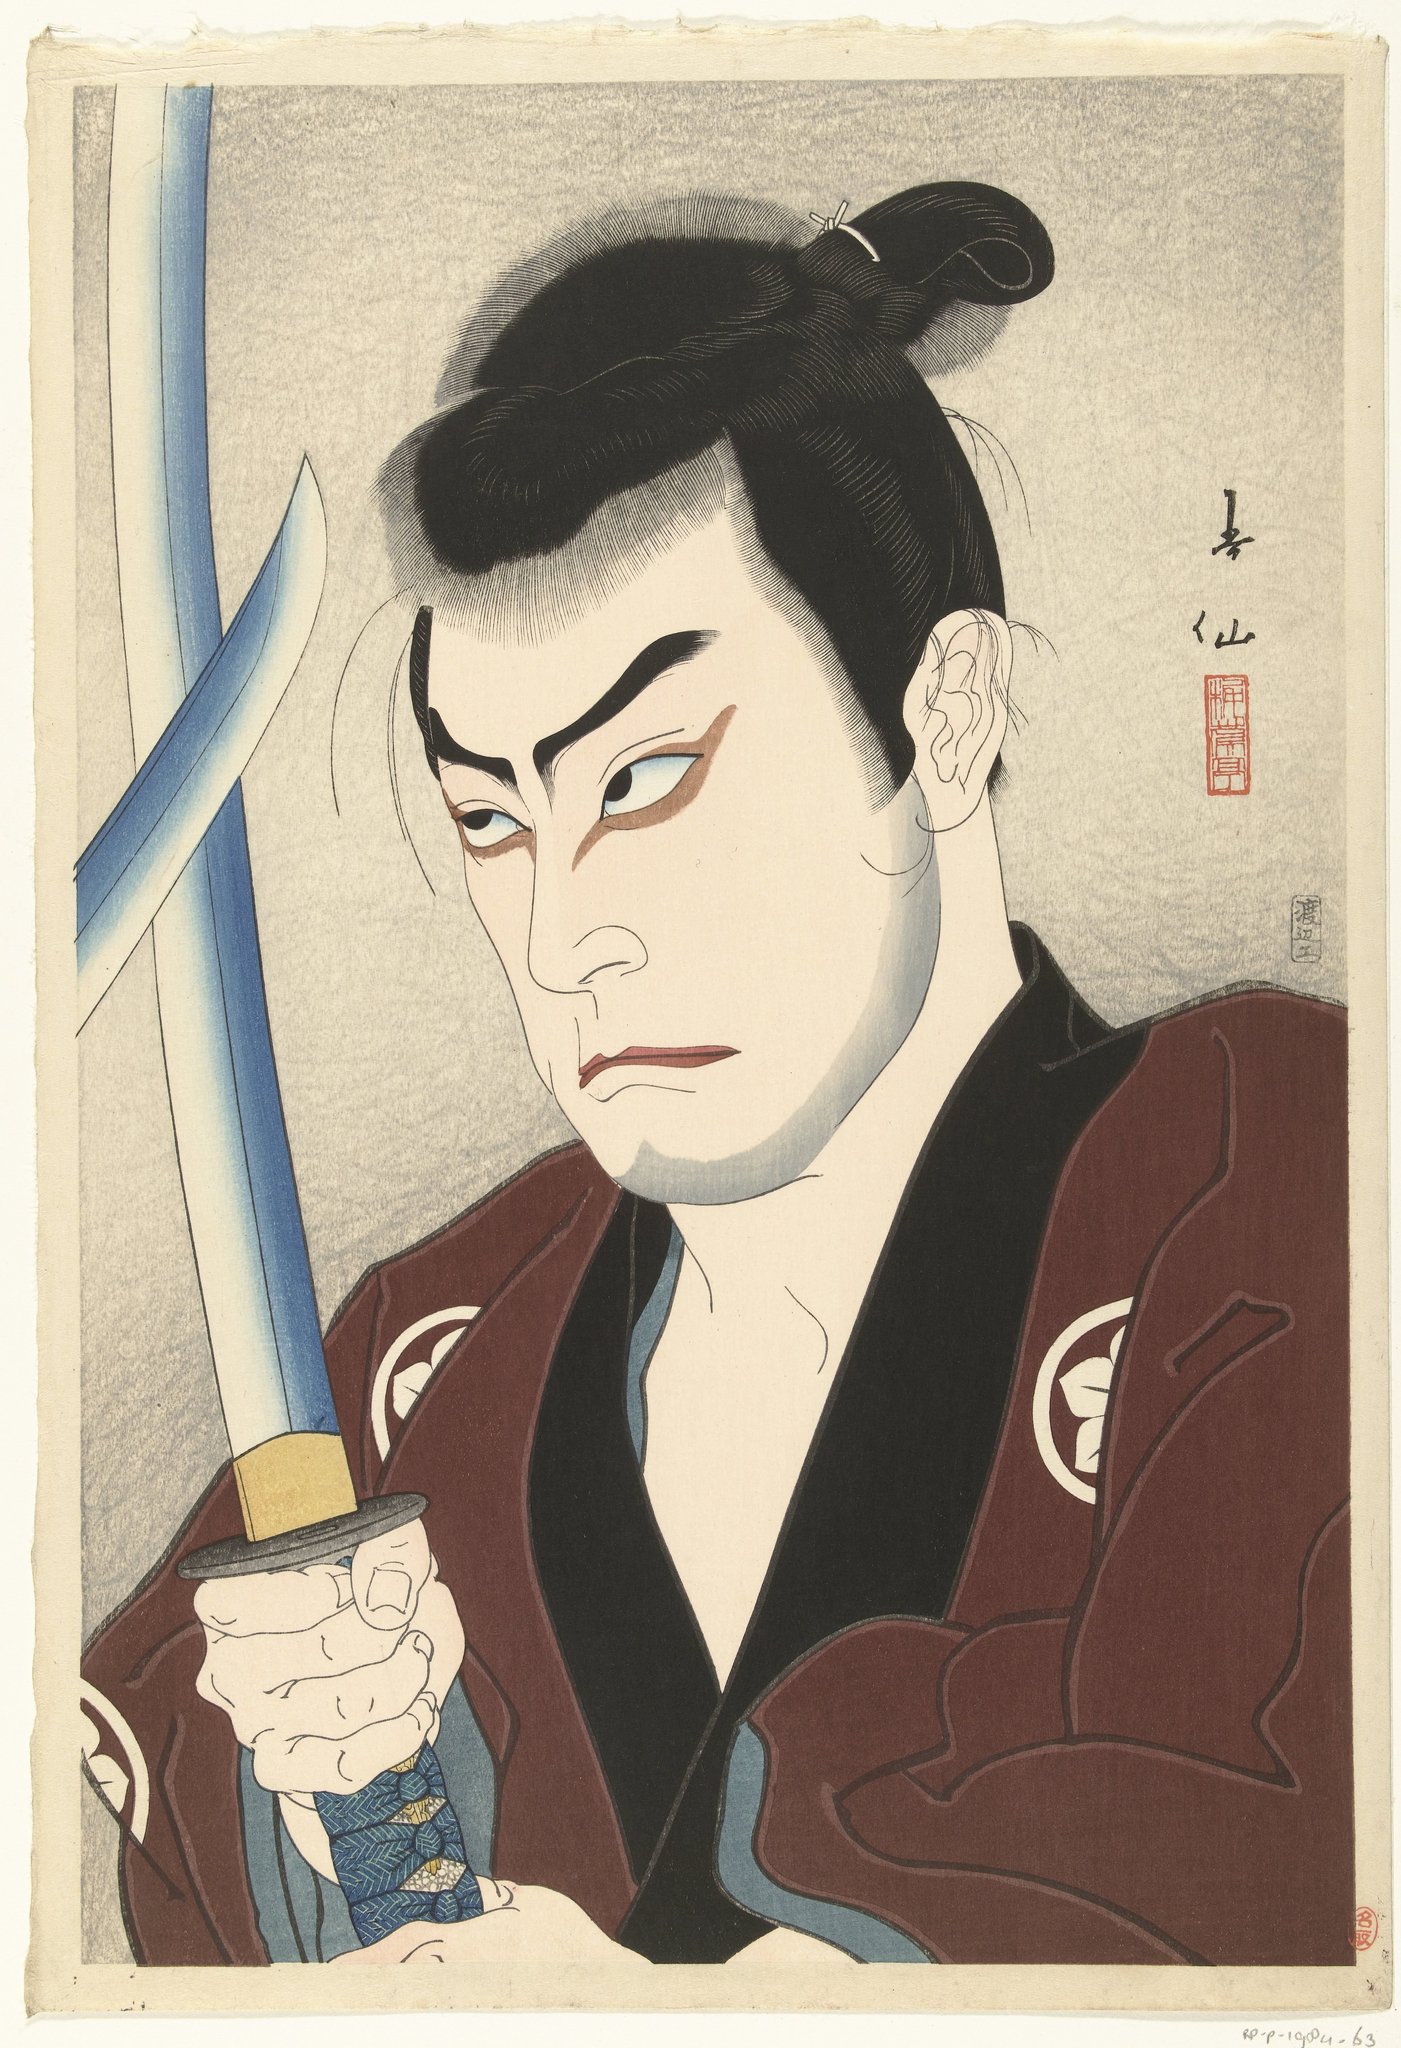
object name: print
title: De acteur Sawada Shojiro als Hayashi Buhei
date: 1927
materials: paper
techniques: woodcut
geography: japan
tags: hacking and thrusting weapons: sword, portrait of actor, actress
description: Busteportret van de acteur Sawada Shojiro in de rol van Hayashi Buhei, het zwaard gekruist met dat van een tegenstander.